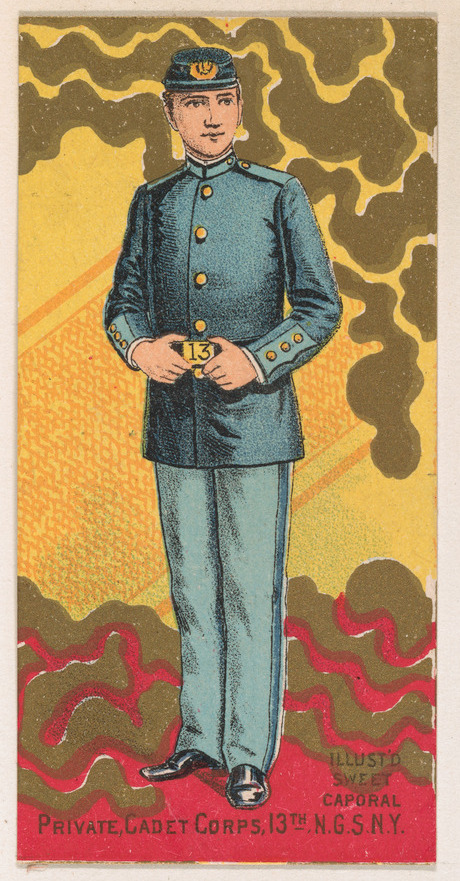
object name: print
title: Private, Cadet Corps, 13th Regiment, National Guard of the State of New York, from the Military Series (N224) issued by Kinney Tobacco Company to promote Sweet Caporal Cigarettes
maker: kinney brothers tobacco company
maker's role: publisher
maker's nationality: american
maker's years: 1869-2011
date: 1888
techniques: color lithograph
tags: soldiers,men